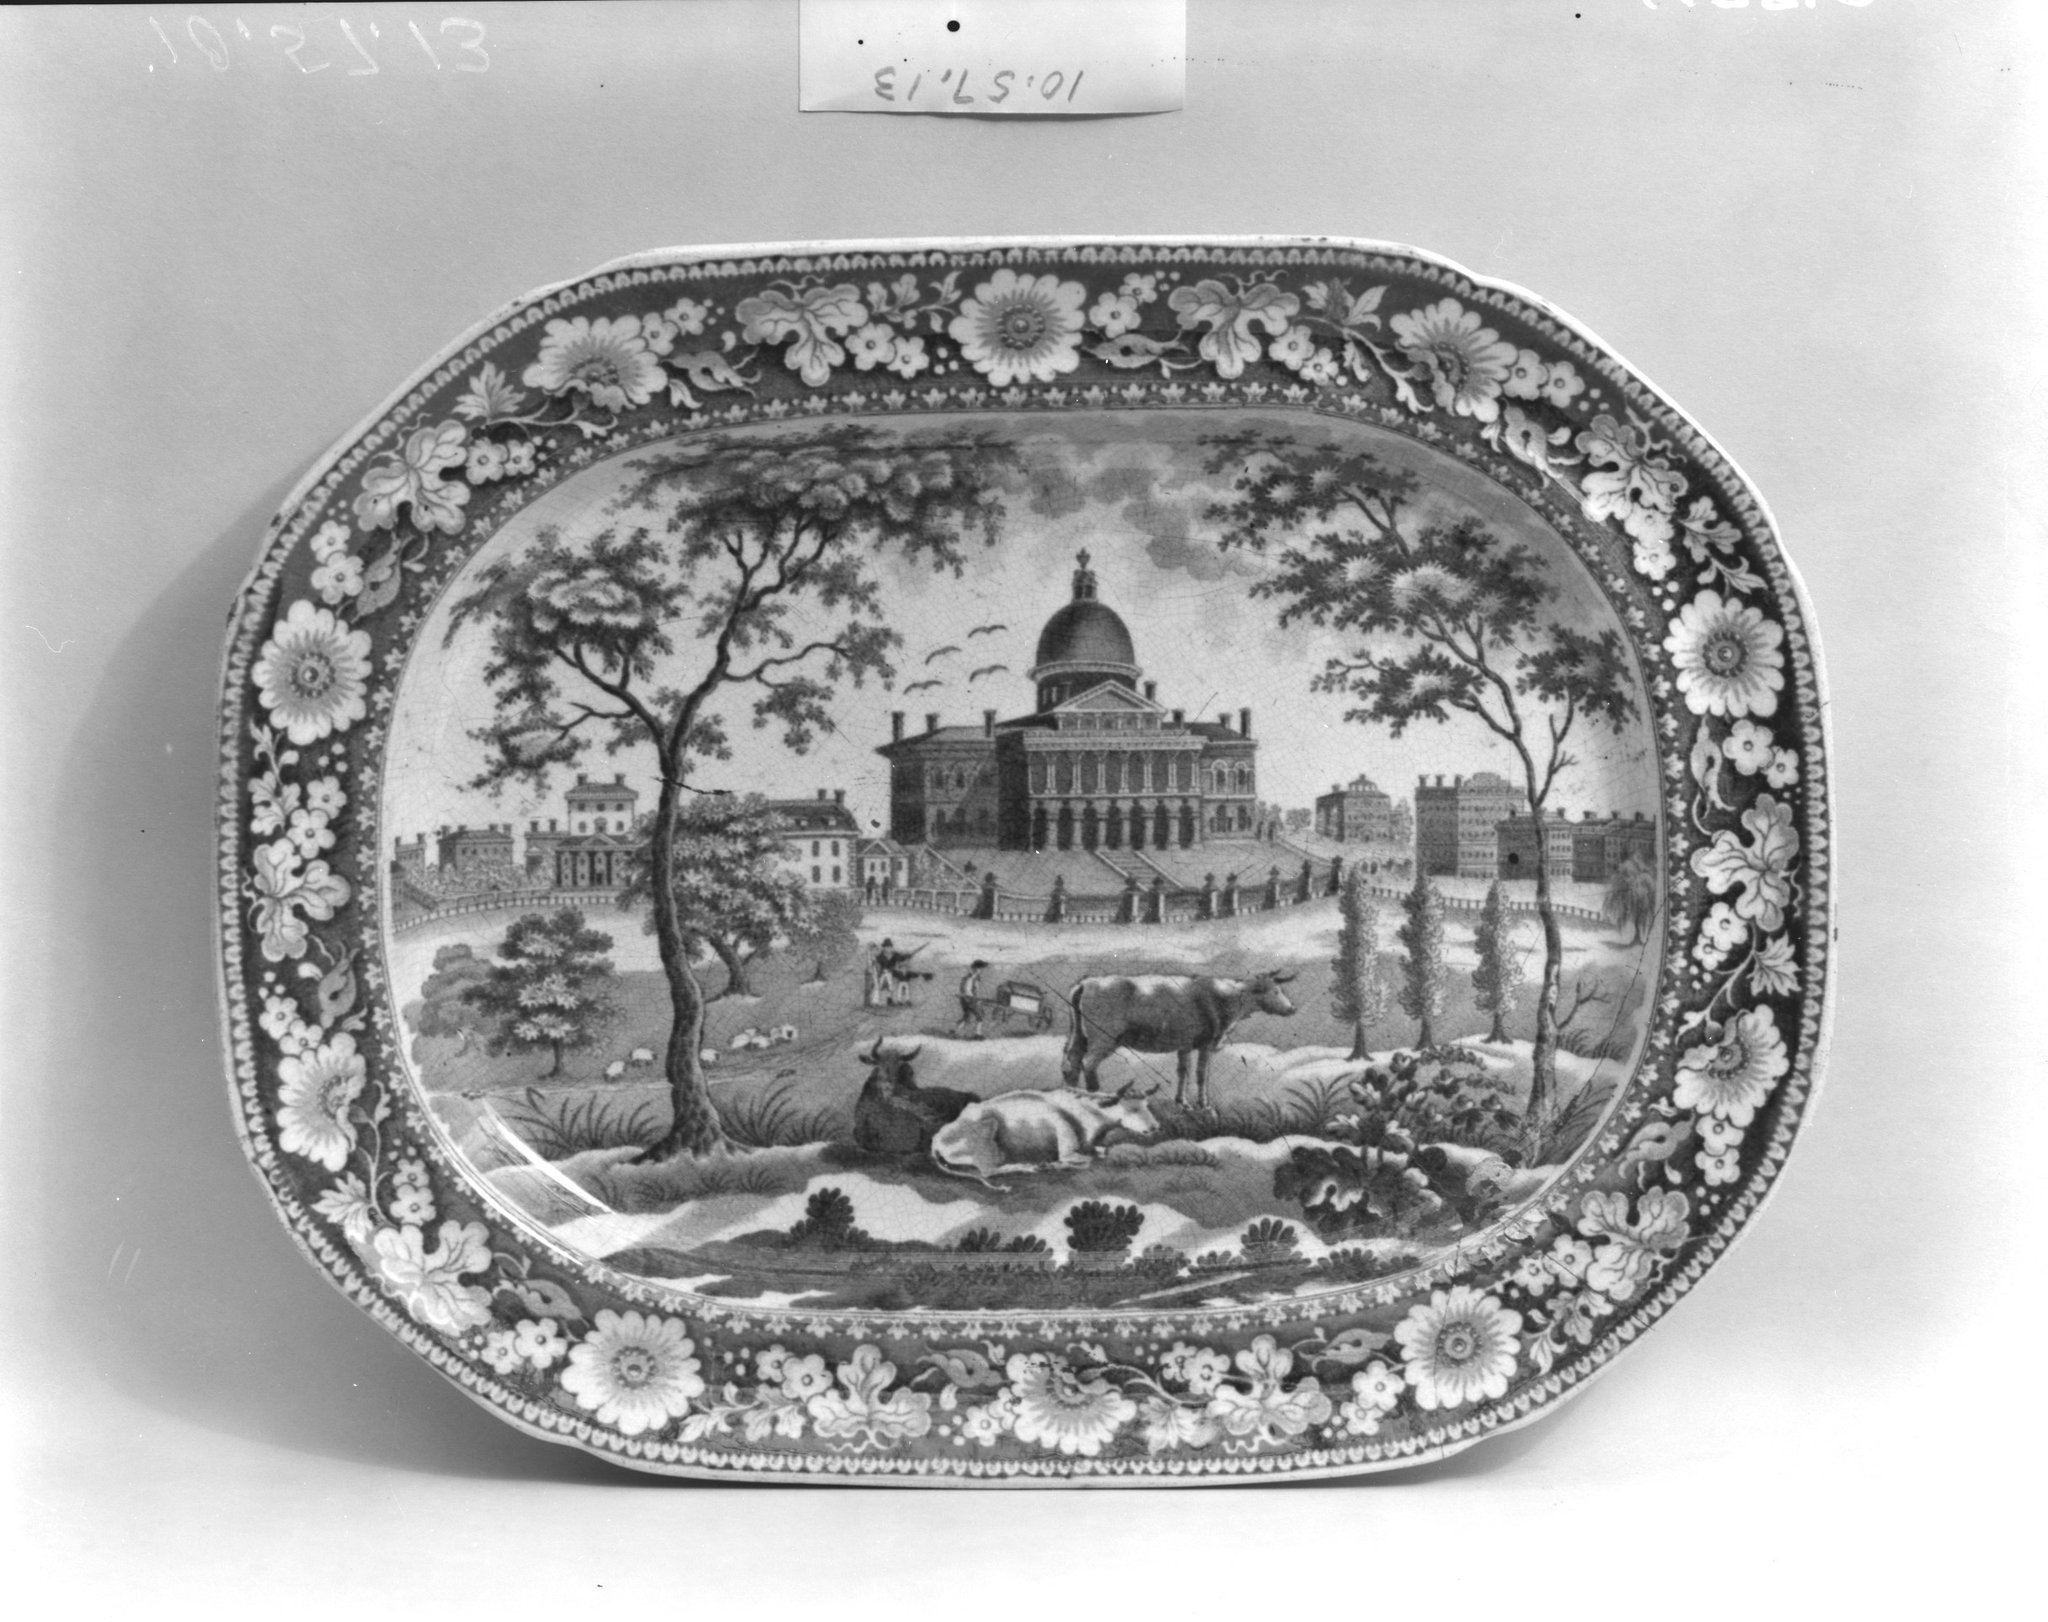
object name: platter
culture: british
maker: john rogers & son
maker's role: maker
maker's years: 1812-1842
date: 1815-1842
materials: earthenware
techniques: transfer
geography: england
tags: buildings,cows,trees